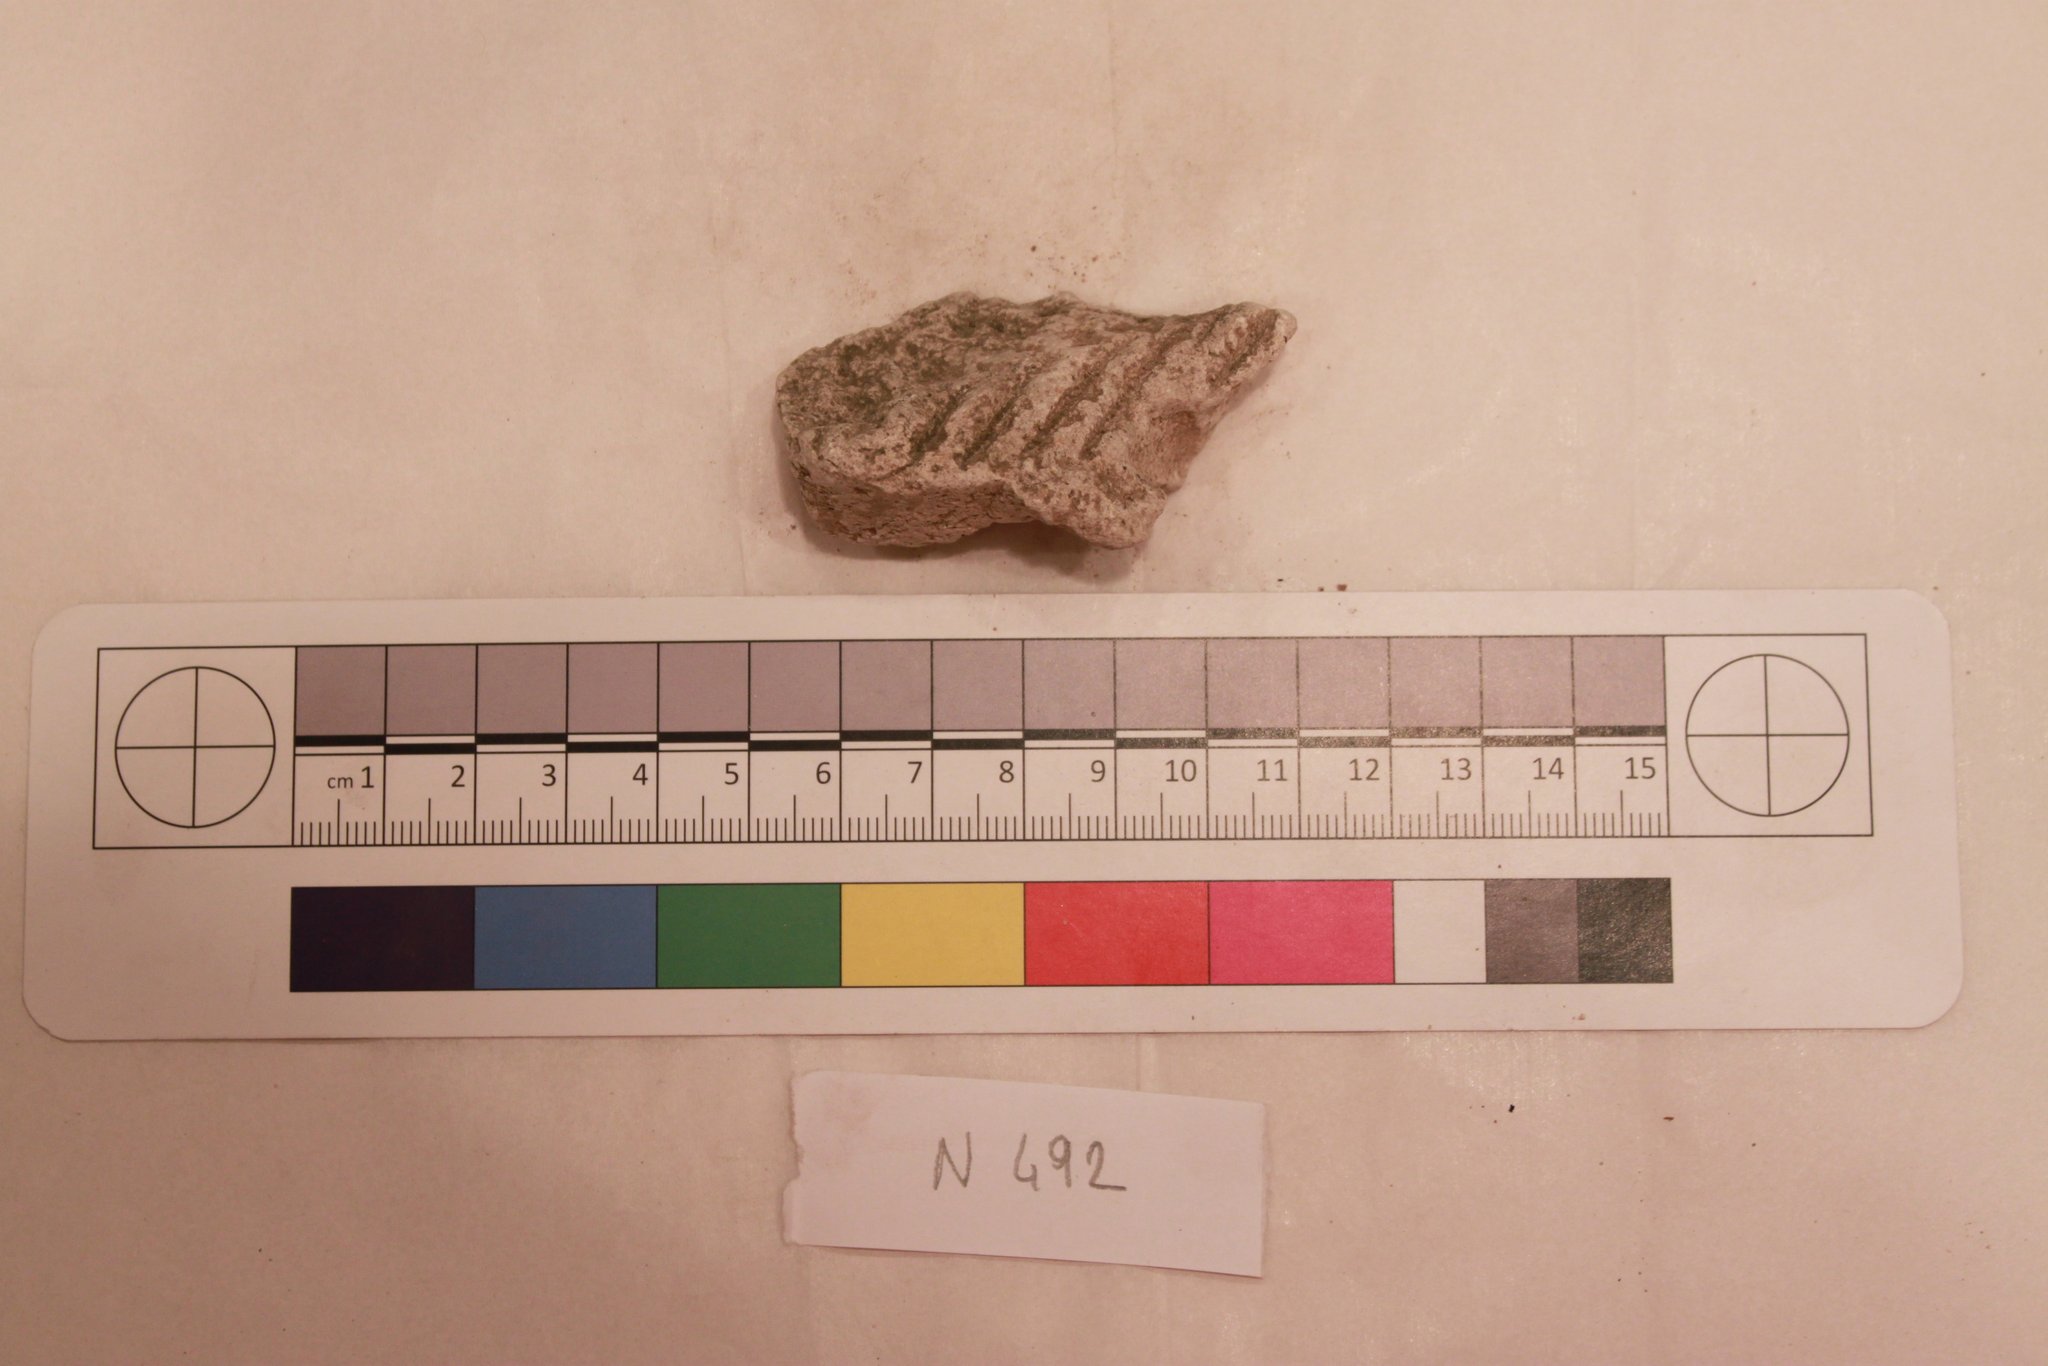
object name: fragment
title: Stucco Fragment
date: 701-1200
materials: plaster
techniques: carving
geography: iran